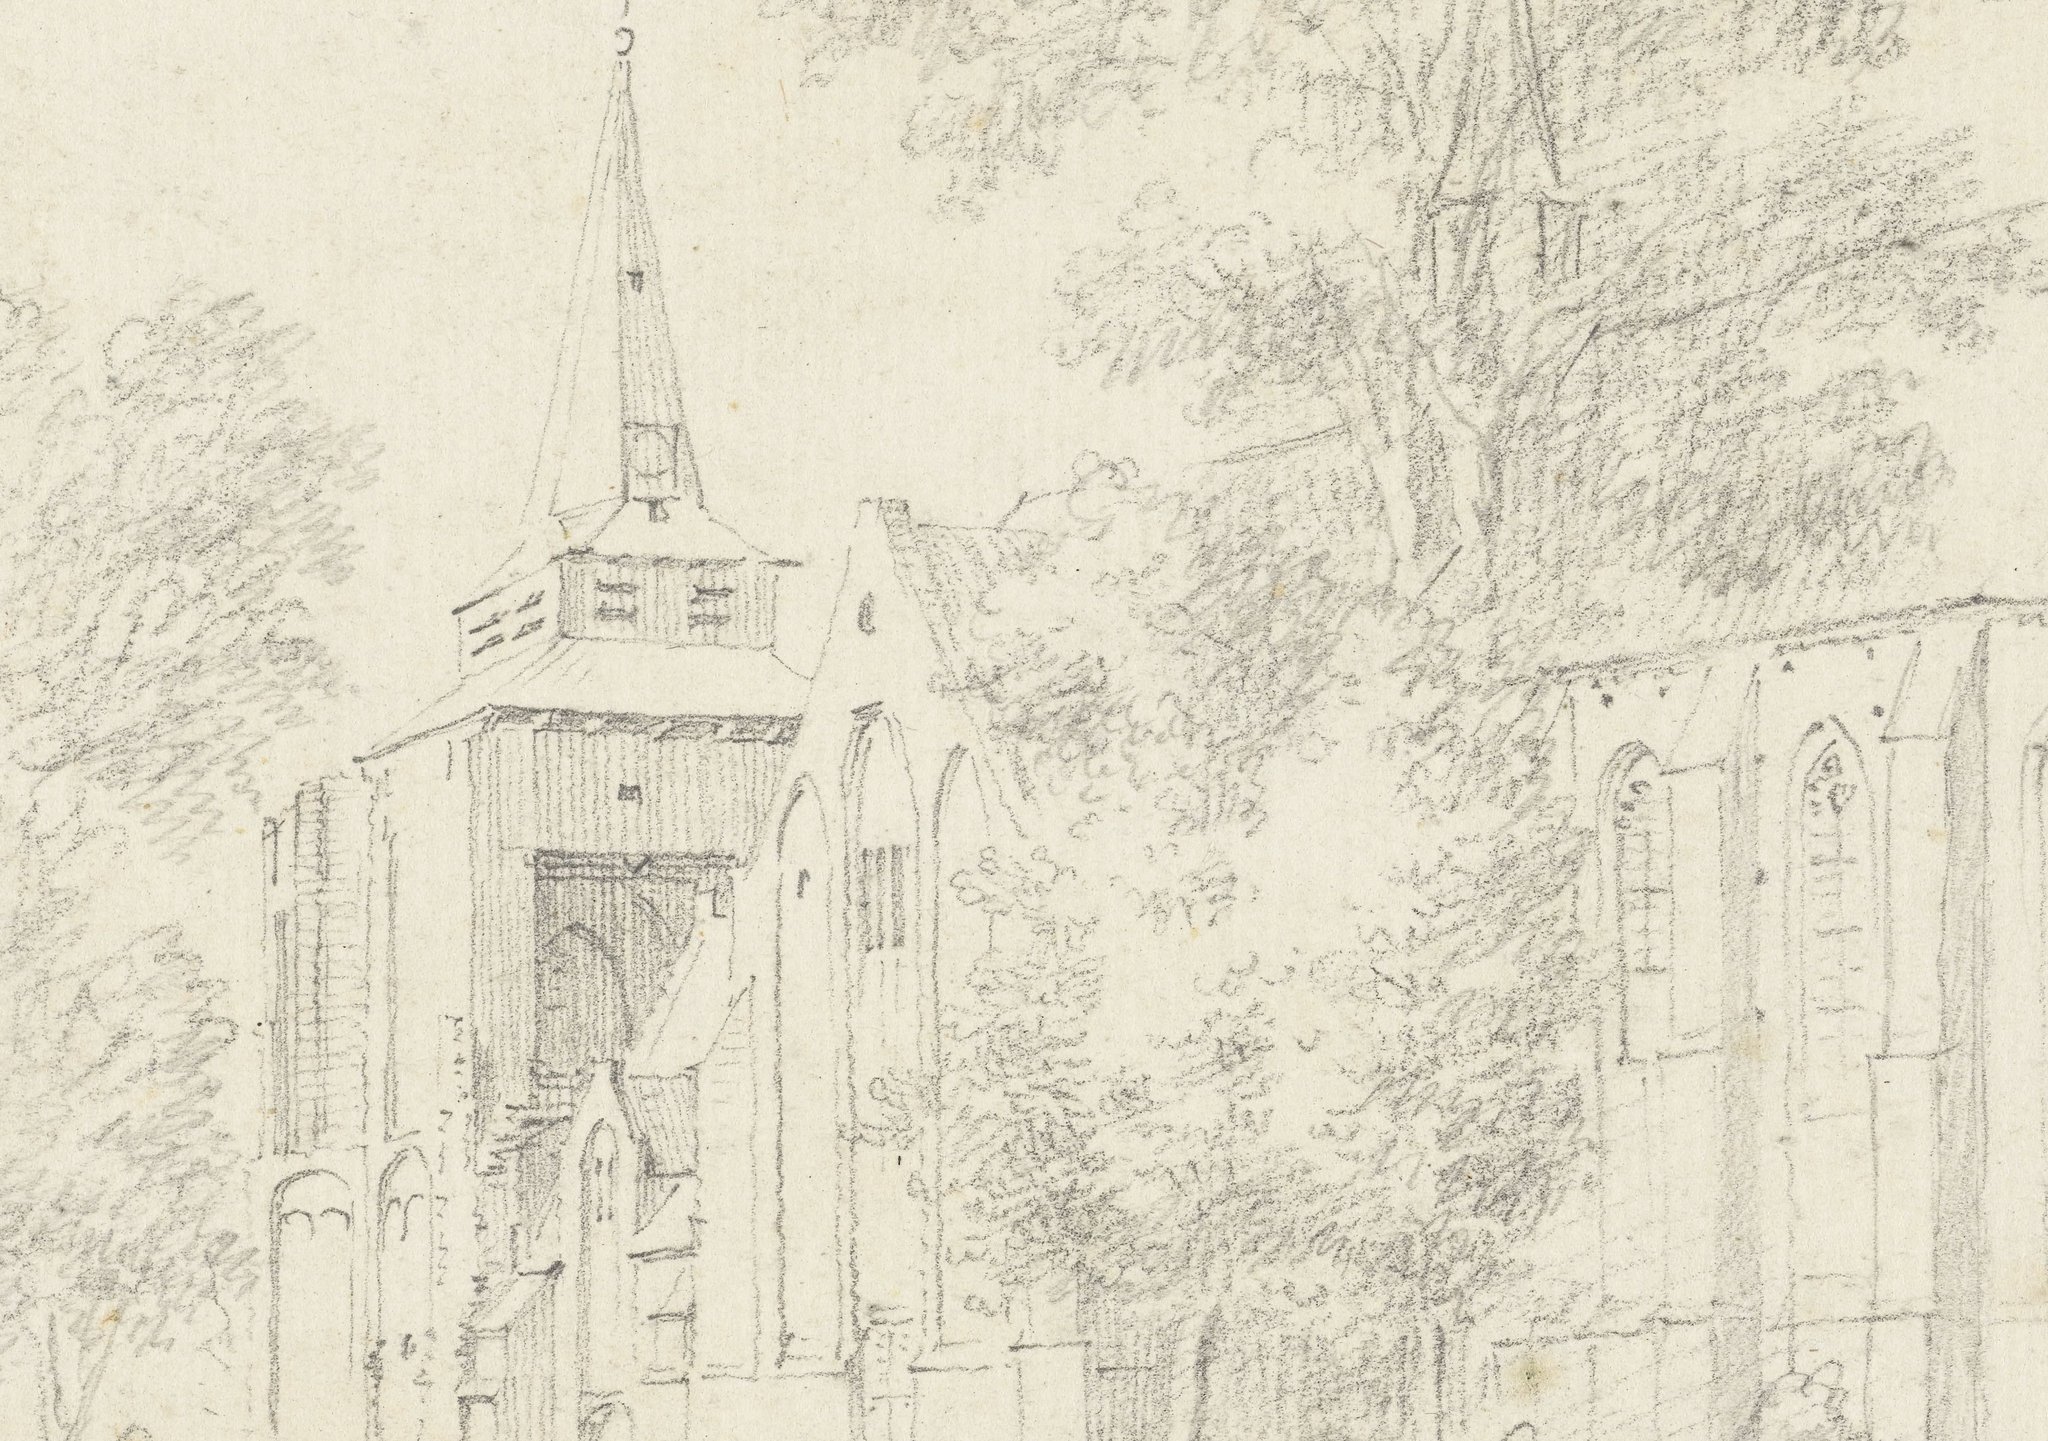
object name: drawing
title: De kerk te Erp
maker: Anonymous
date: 1700-1800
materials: paper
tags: church (exterior)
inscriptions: inscription: ‘Erp’